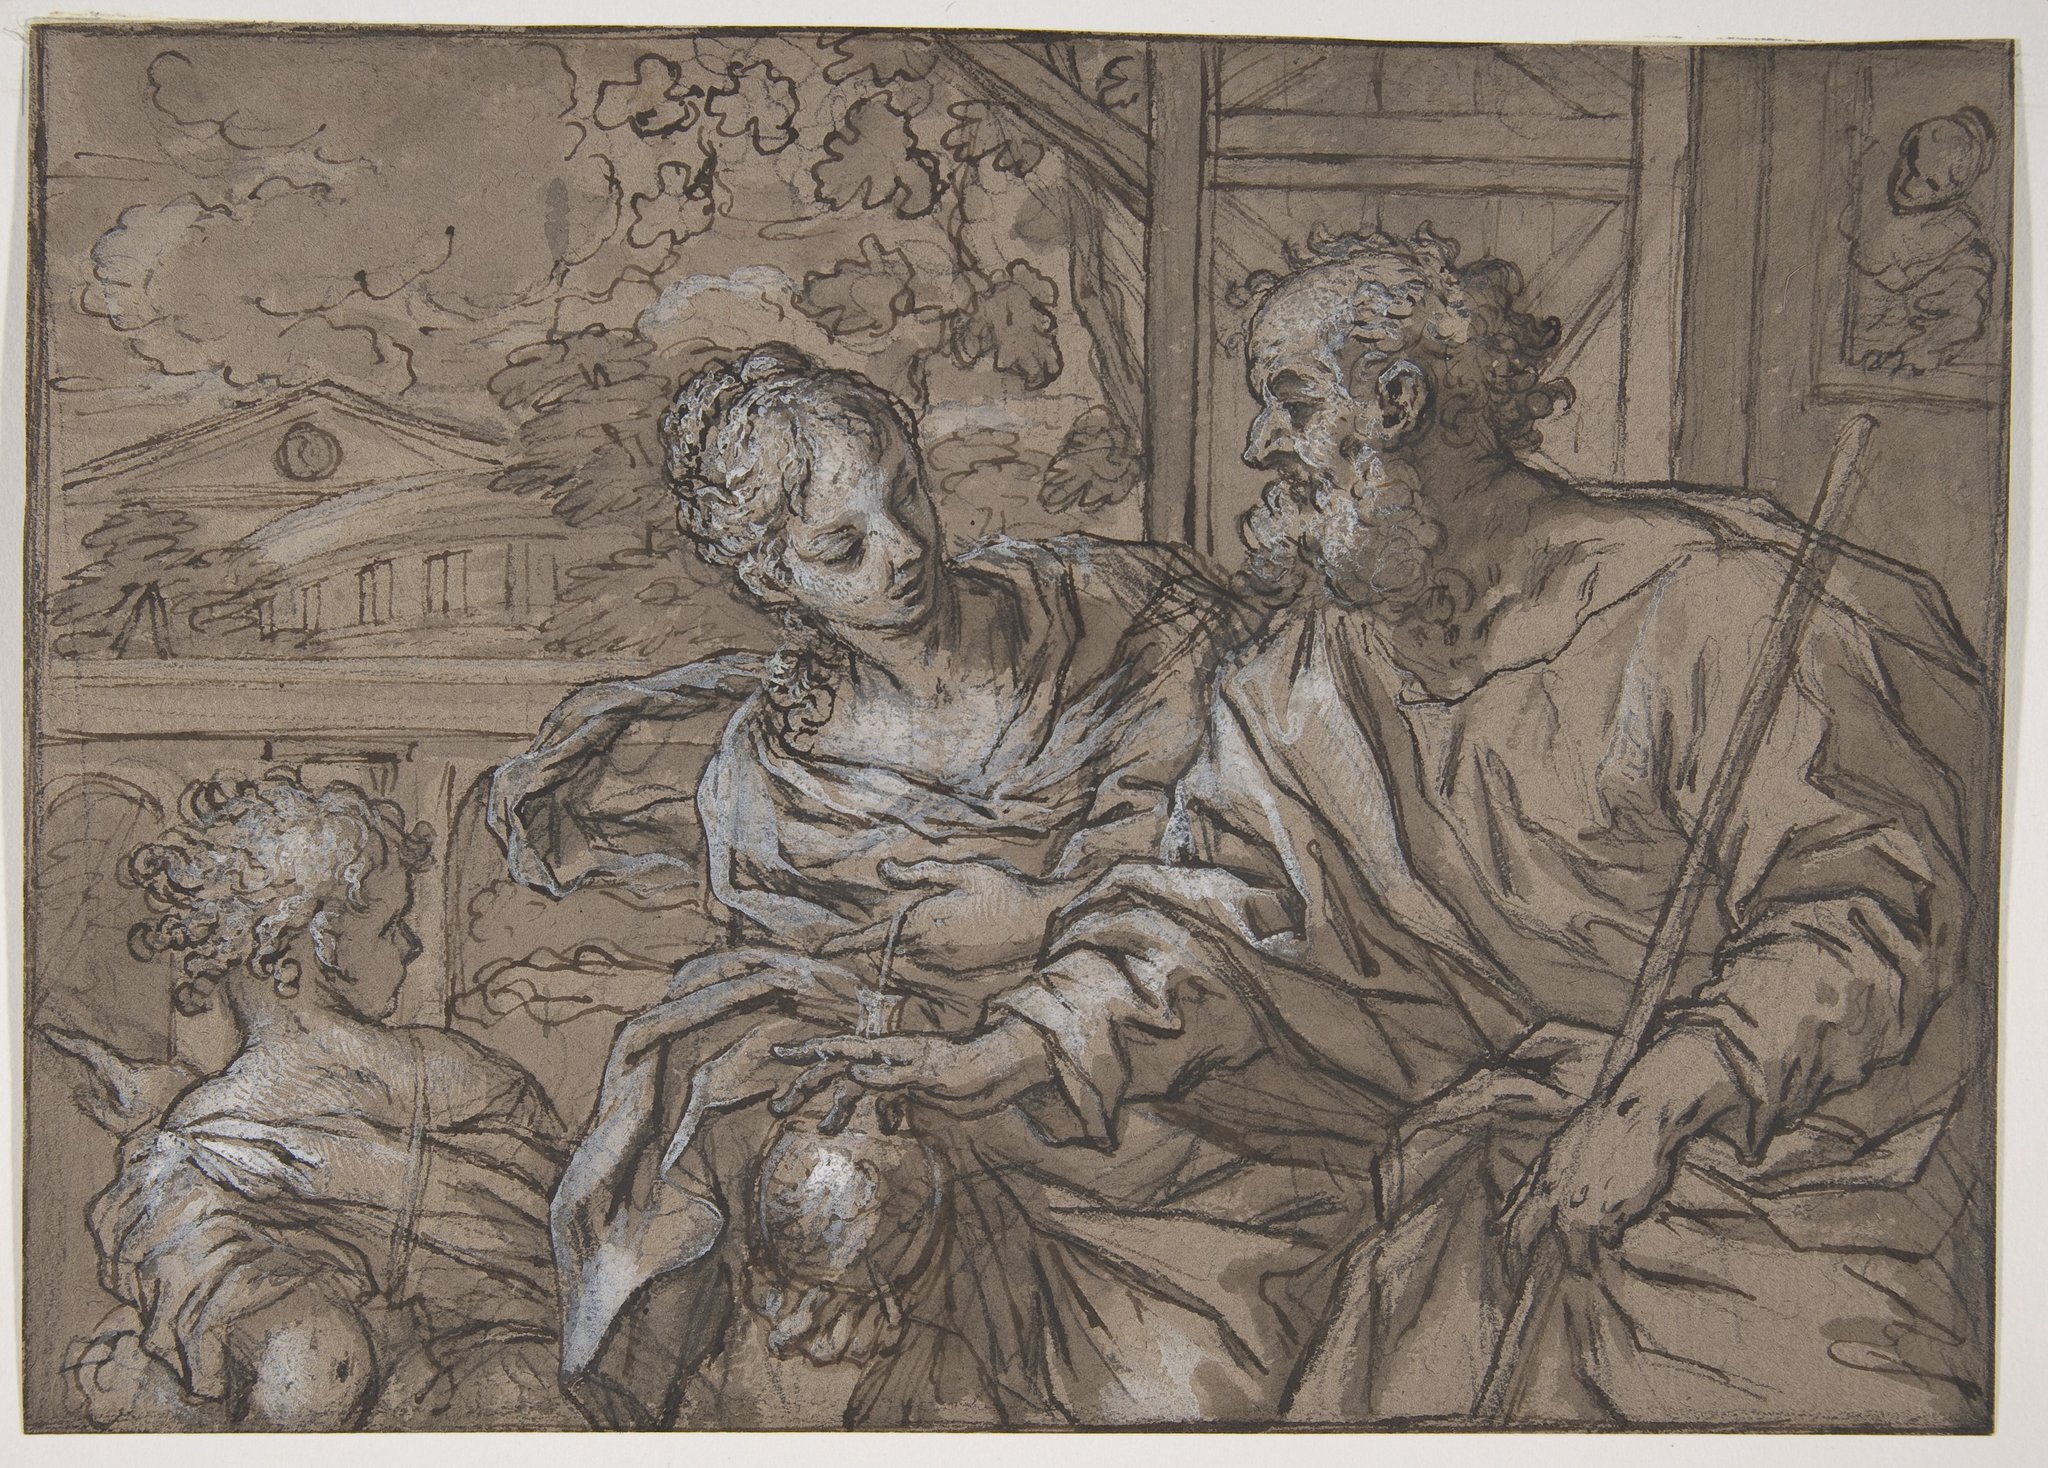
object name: drawing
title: The Dismissal of Hagar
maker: giuseppe nicola nasini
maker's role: artist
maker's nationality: italian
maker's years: 1657-1736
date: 1657-1736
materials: chalk, ink, paper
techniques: brush, highlighting, pen, wash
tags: boys,men,women